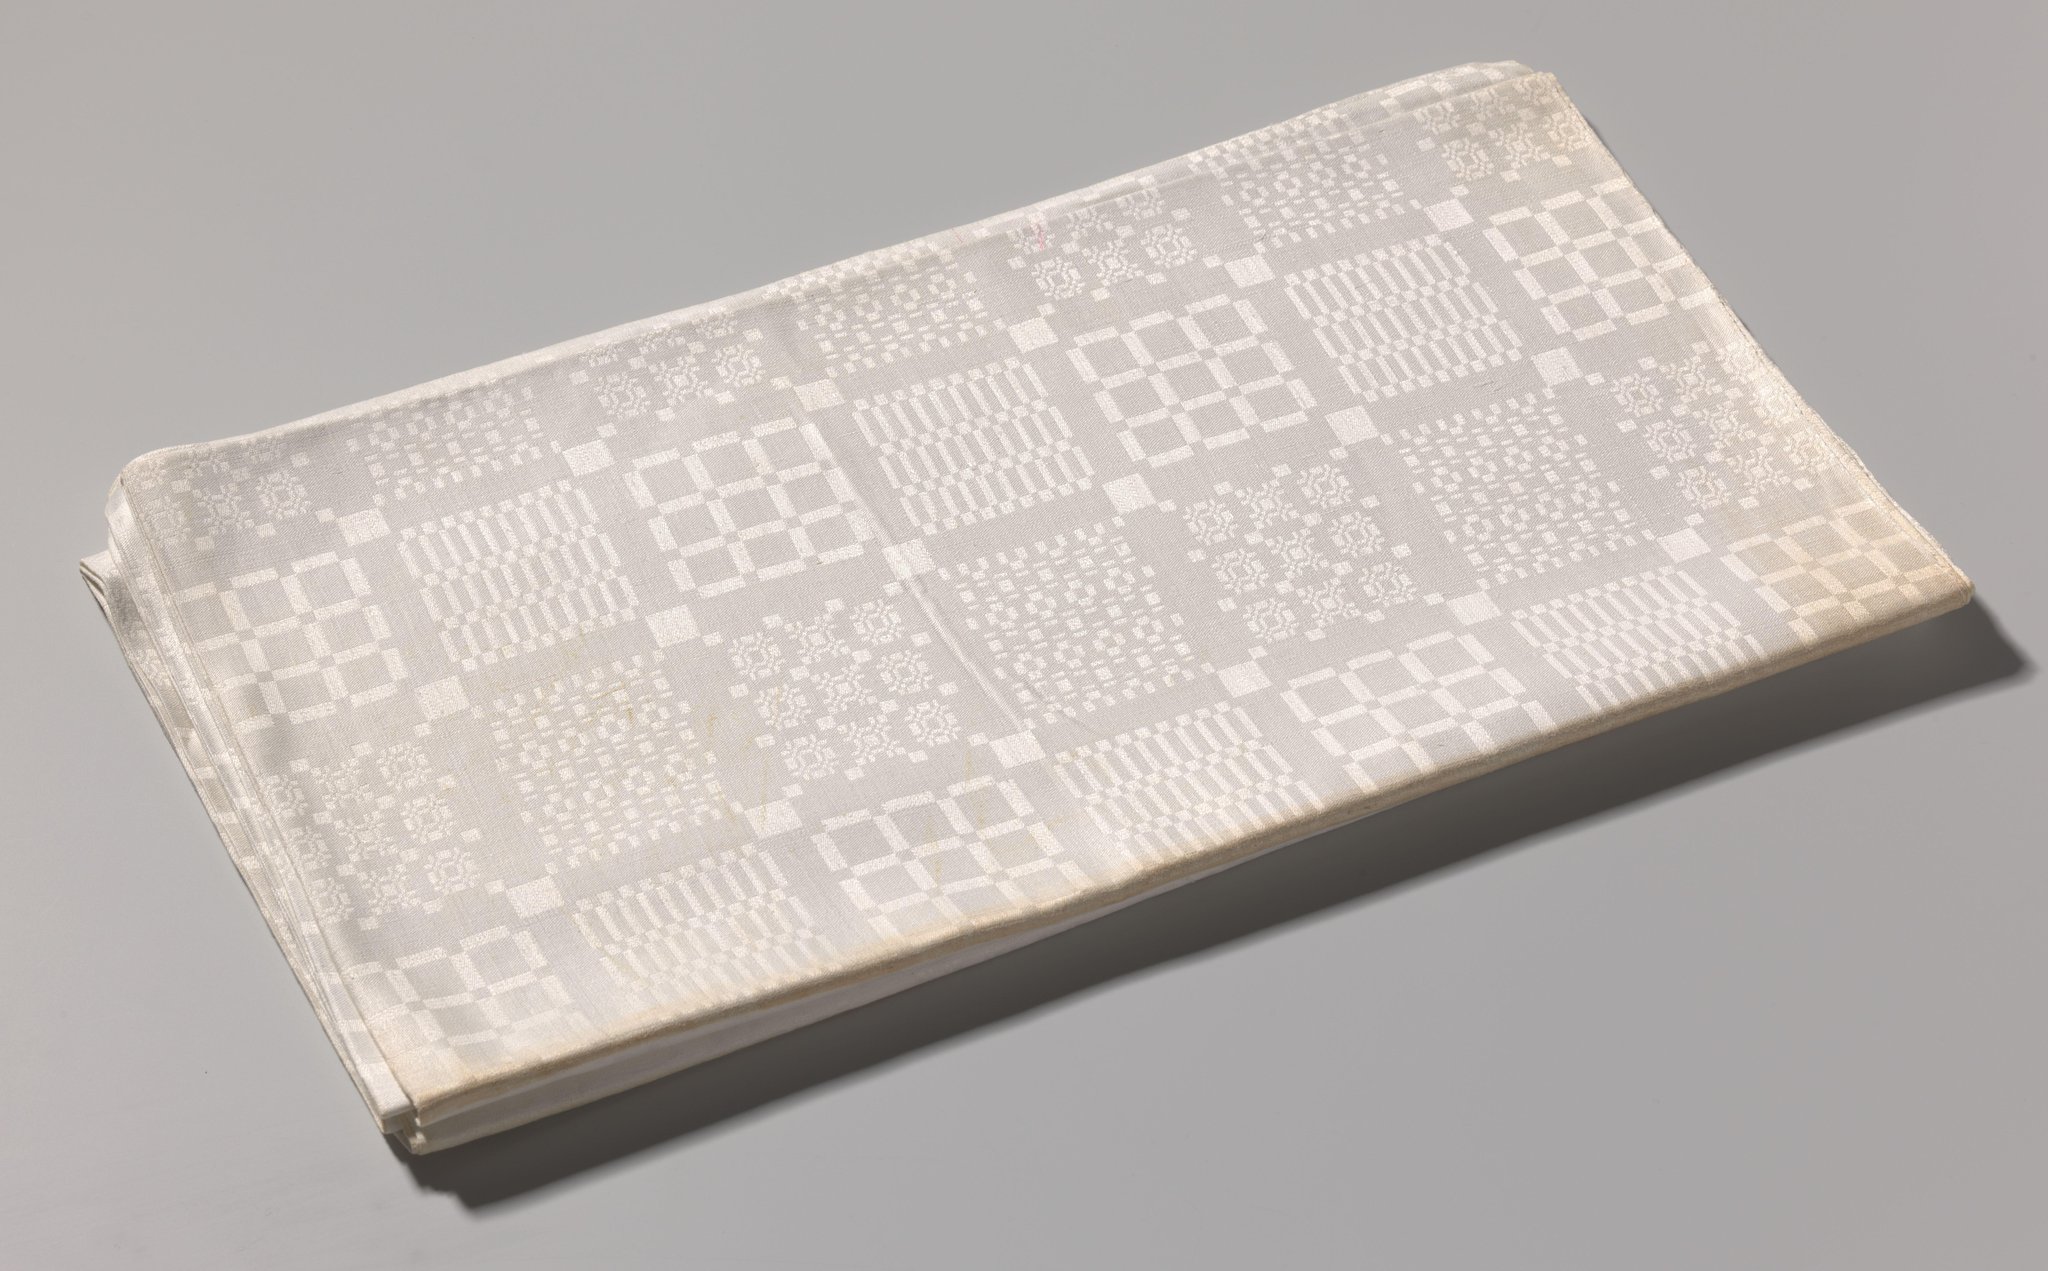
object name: tablecloth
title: Tafellaken met pellenpatroon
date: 1737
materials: linen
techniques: peeled fabric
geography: northern netherlands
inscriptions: date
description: Wit linnen tafellaken met een pellenpatroon in keperbinden, genaamd "Oostindische caracters". Merk kroon WG 5 en 1737.